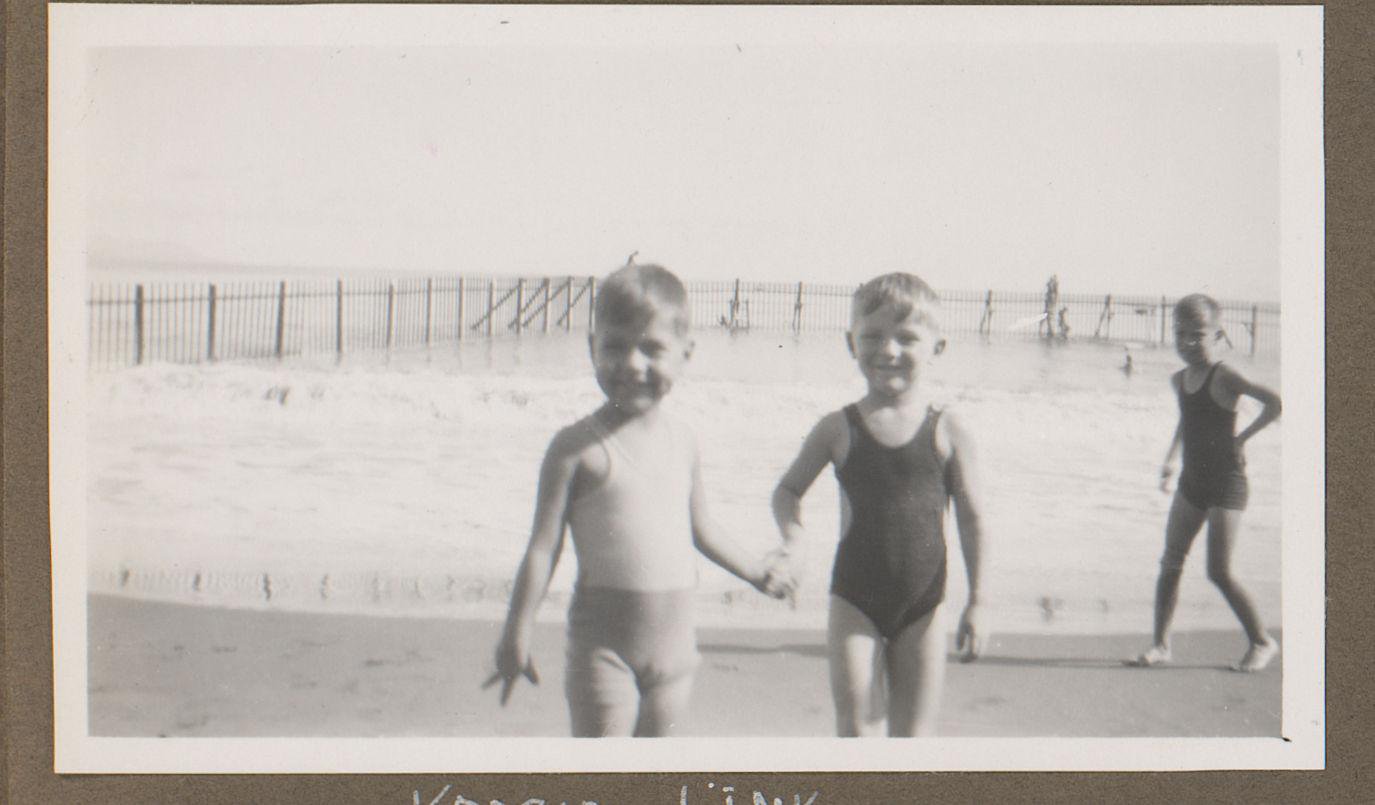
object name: photograph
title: Portret van Keesje Link en twee andere kinderen op het strand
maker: Anonymous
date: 1934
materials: paper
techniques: gelatin silver print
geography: netherlands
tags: beach (as place of recreation), boy (child between toddler and youth), historical persons not known by name, netherlands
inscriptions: inscription: ‘Keesje Link.’